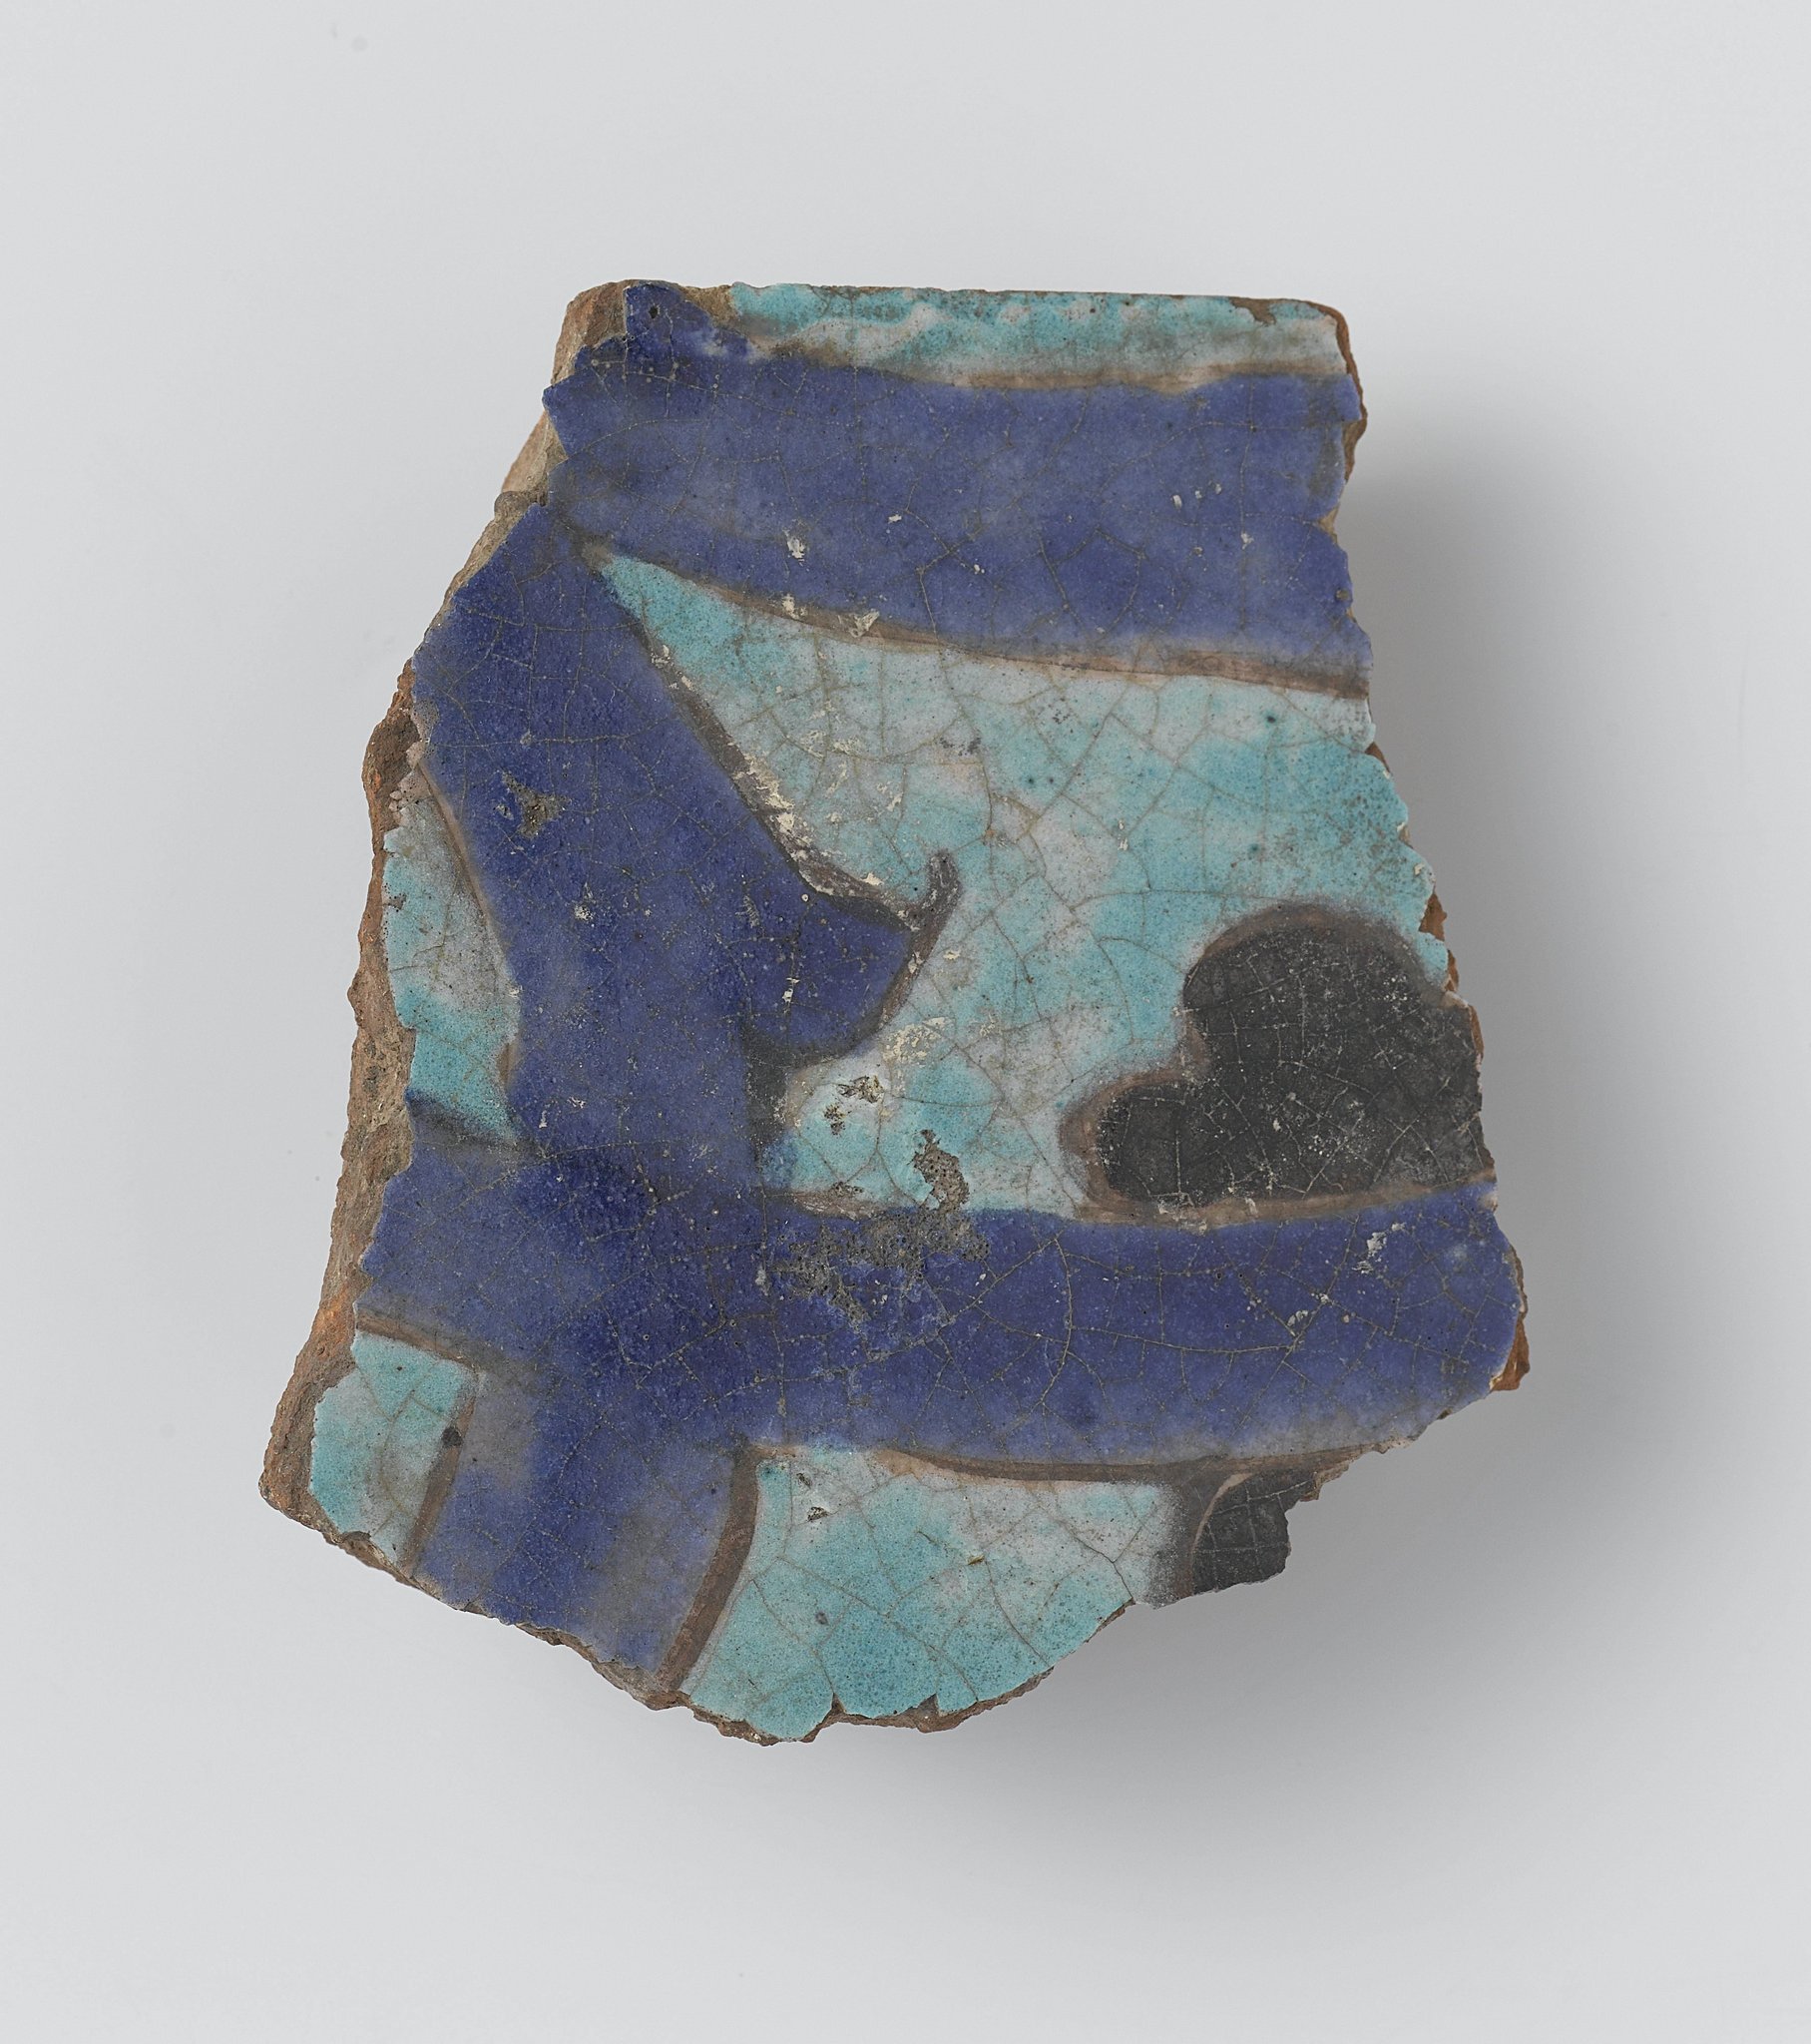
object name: tile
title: Tile fragment with a turquoise and blue glaze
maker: Anonymous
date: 1350-1499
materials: earthenware, glaze, paint, quartz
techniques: firing, forming, vitrification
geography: iran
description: Fragment van een tegel van hardgebakken rode aarde, aan een zijde bedekt met een turquoise en blauw gekleurd glazuur. Het ornament, bestaande uit blauwe banden op een lichtgroene grond, is uit dit fragment niet te reconstrueren. De tegel heeft aan de achterzijde een nok van aardewerk. Afkomstig uit de moskee van Erivan aan de Sauga, district Erivan, aan de Turks-Perzische grens.